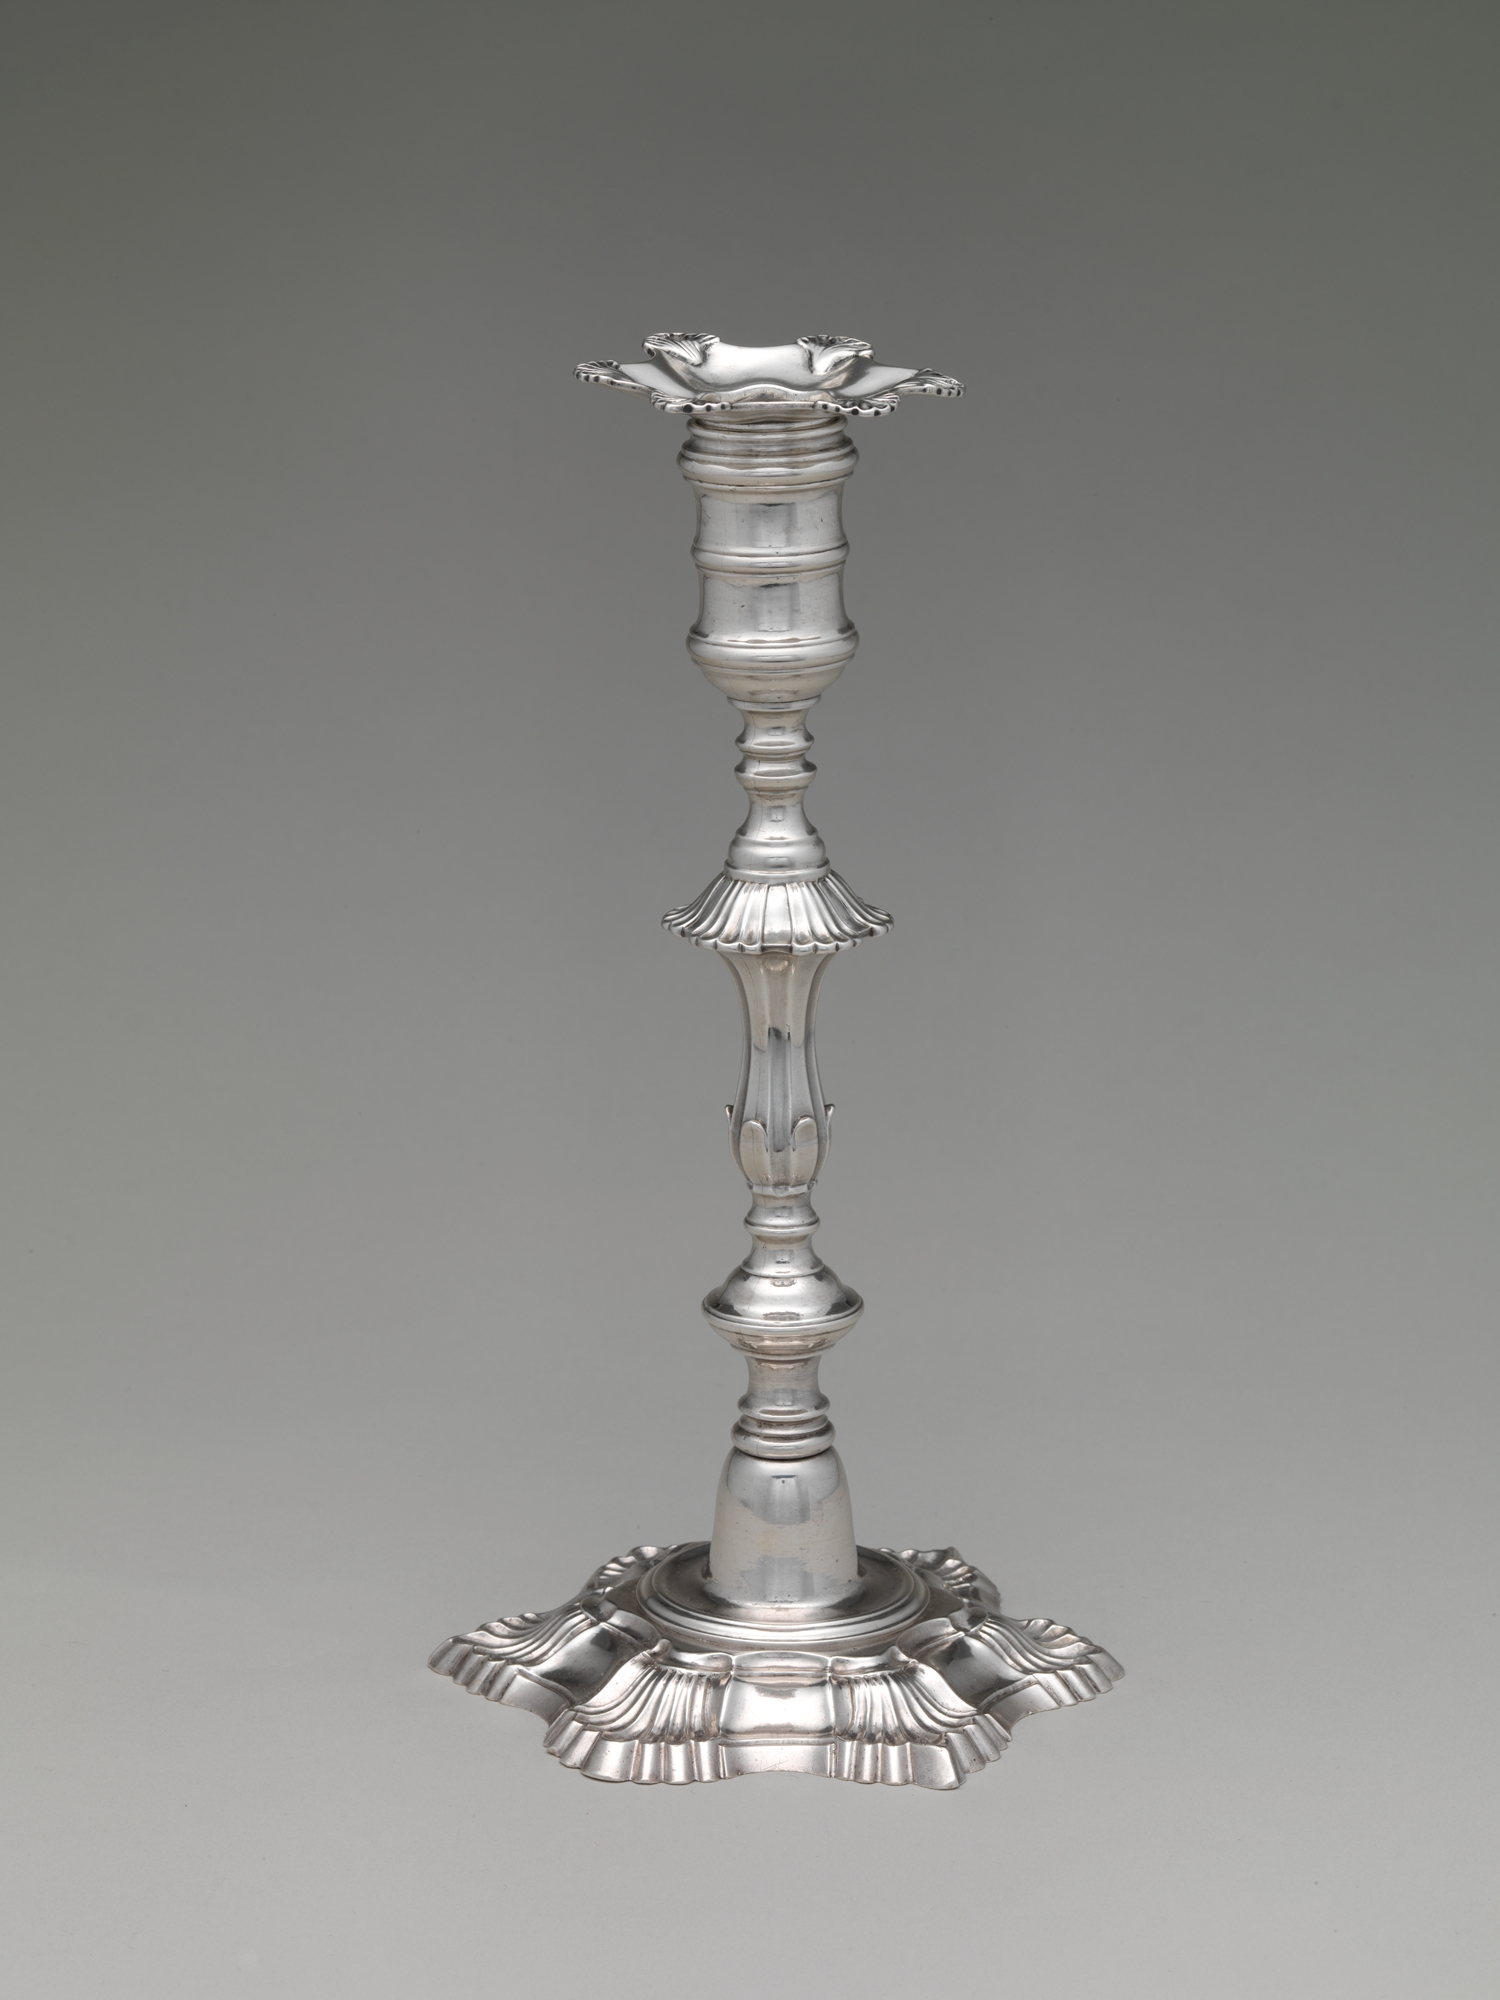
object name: candlestick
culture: american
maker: myer myers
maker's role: maker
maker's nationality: american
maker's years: 1723-1795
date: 1755-1760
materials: silver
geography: united states